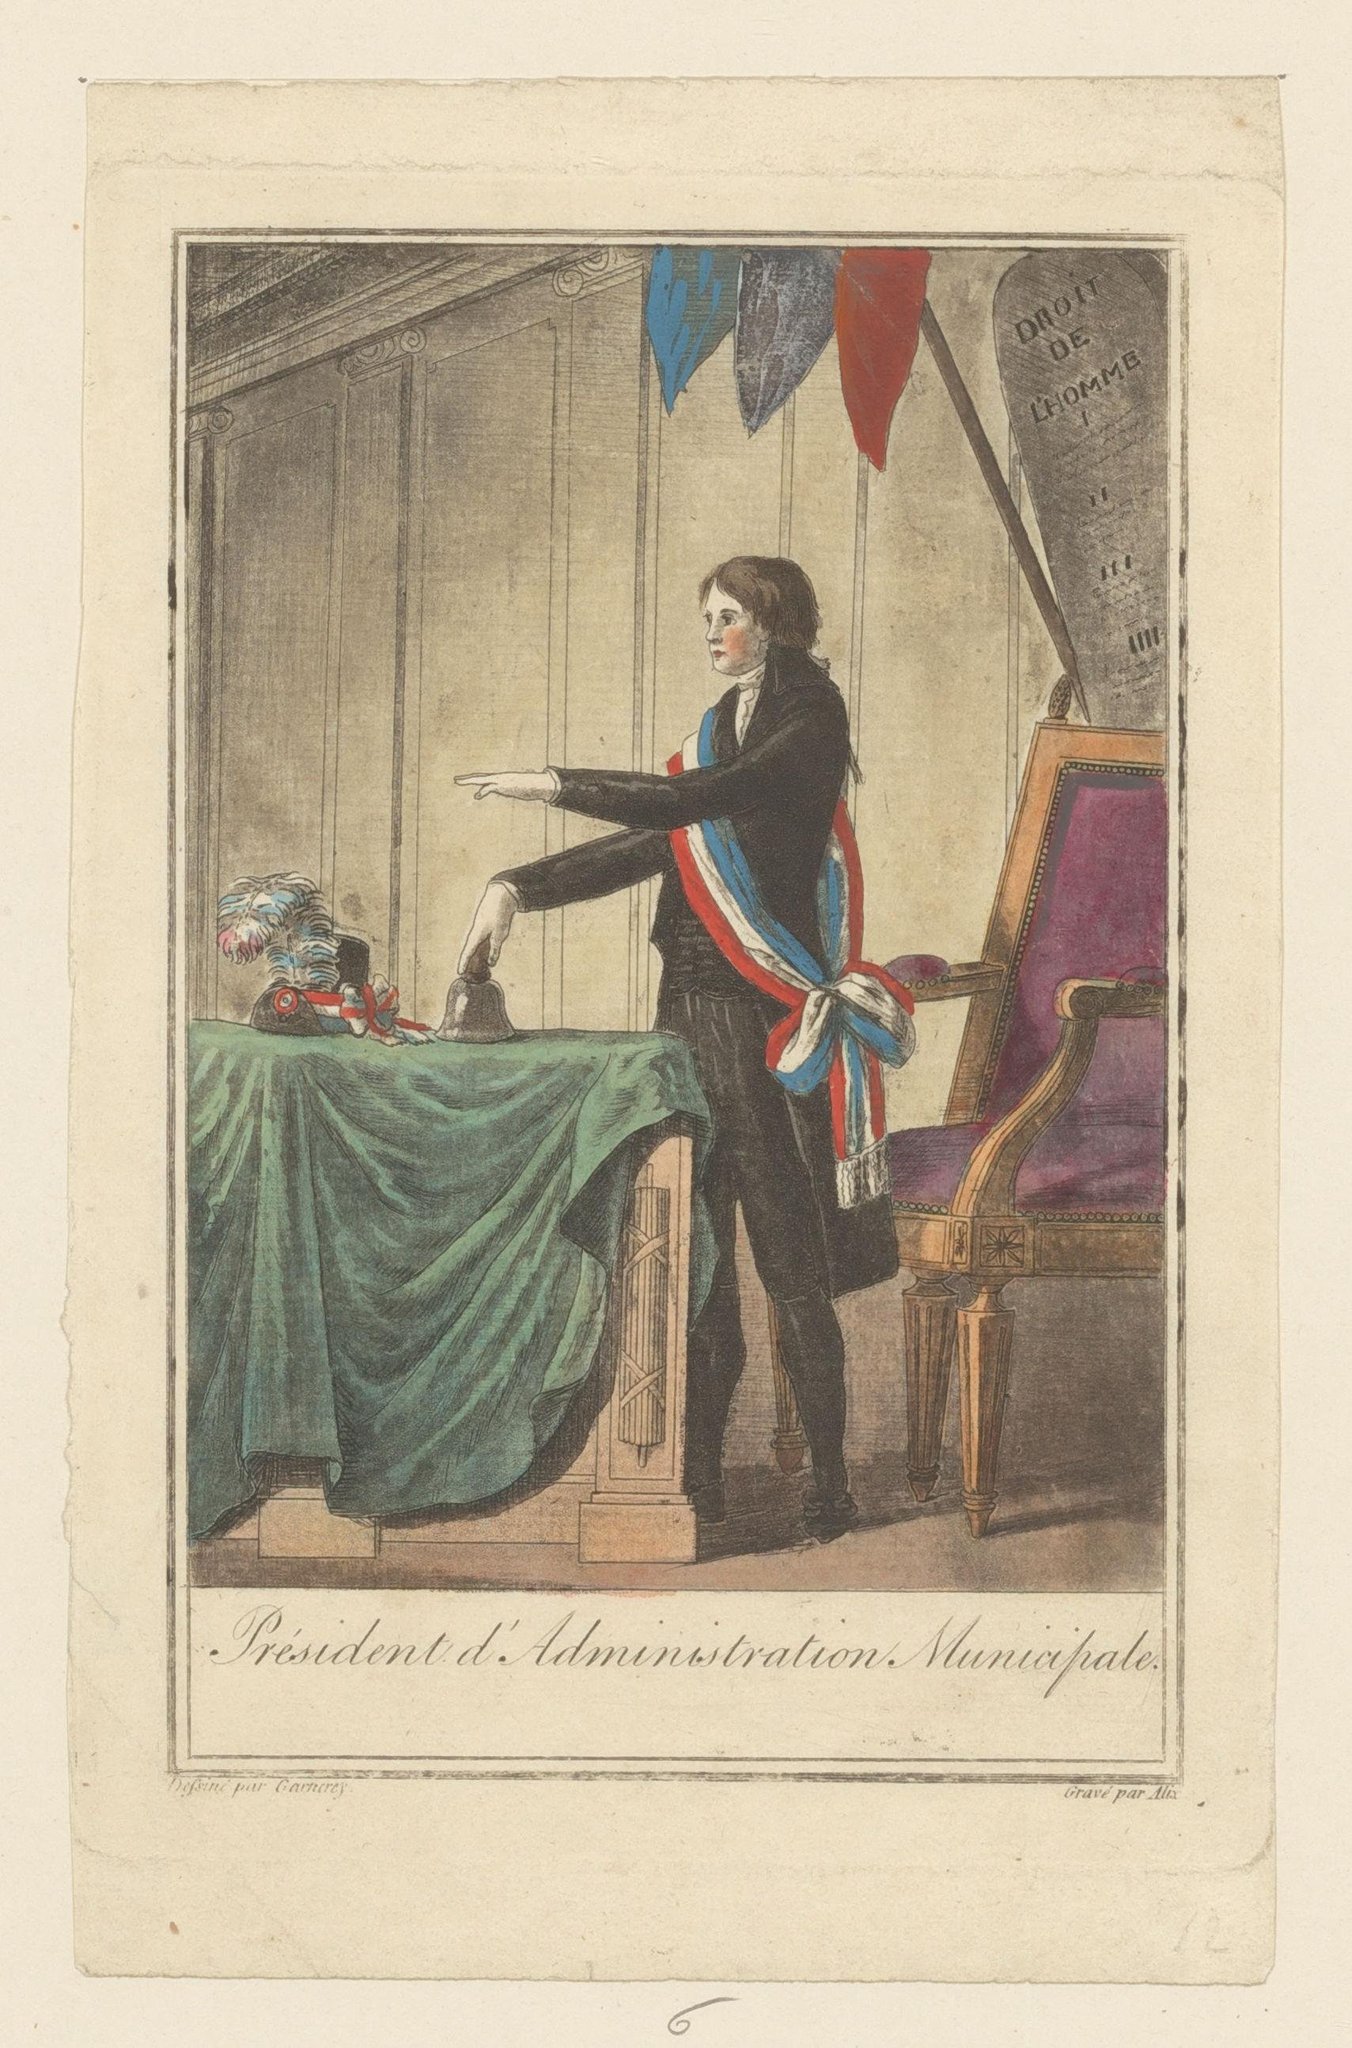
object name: print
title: Kostuum van een minister van het Directoire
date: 1795-1799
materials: paper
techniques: aquatint, etching, hand coloring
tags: minister ~ government, national government, clothes, costume, head-gear: hat (+ feathers used for clothes)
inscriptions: collector's mark: Lugt 1641, stamp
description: Onderwerpsrubrieken binnen de Atlas Zeden en Gewoonten: Zeden en Gewoonten in Engeren Zin, De Kleeding, Kleederdrachten (tijdvakken), De Fransche Revolutie. (Het Directoire).